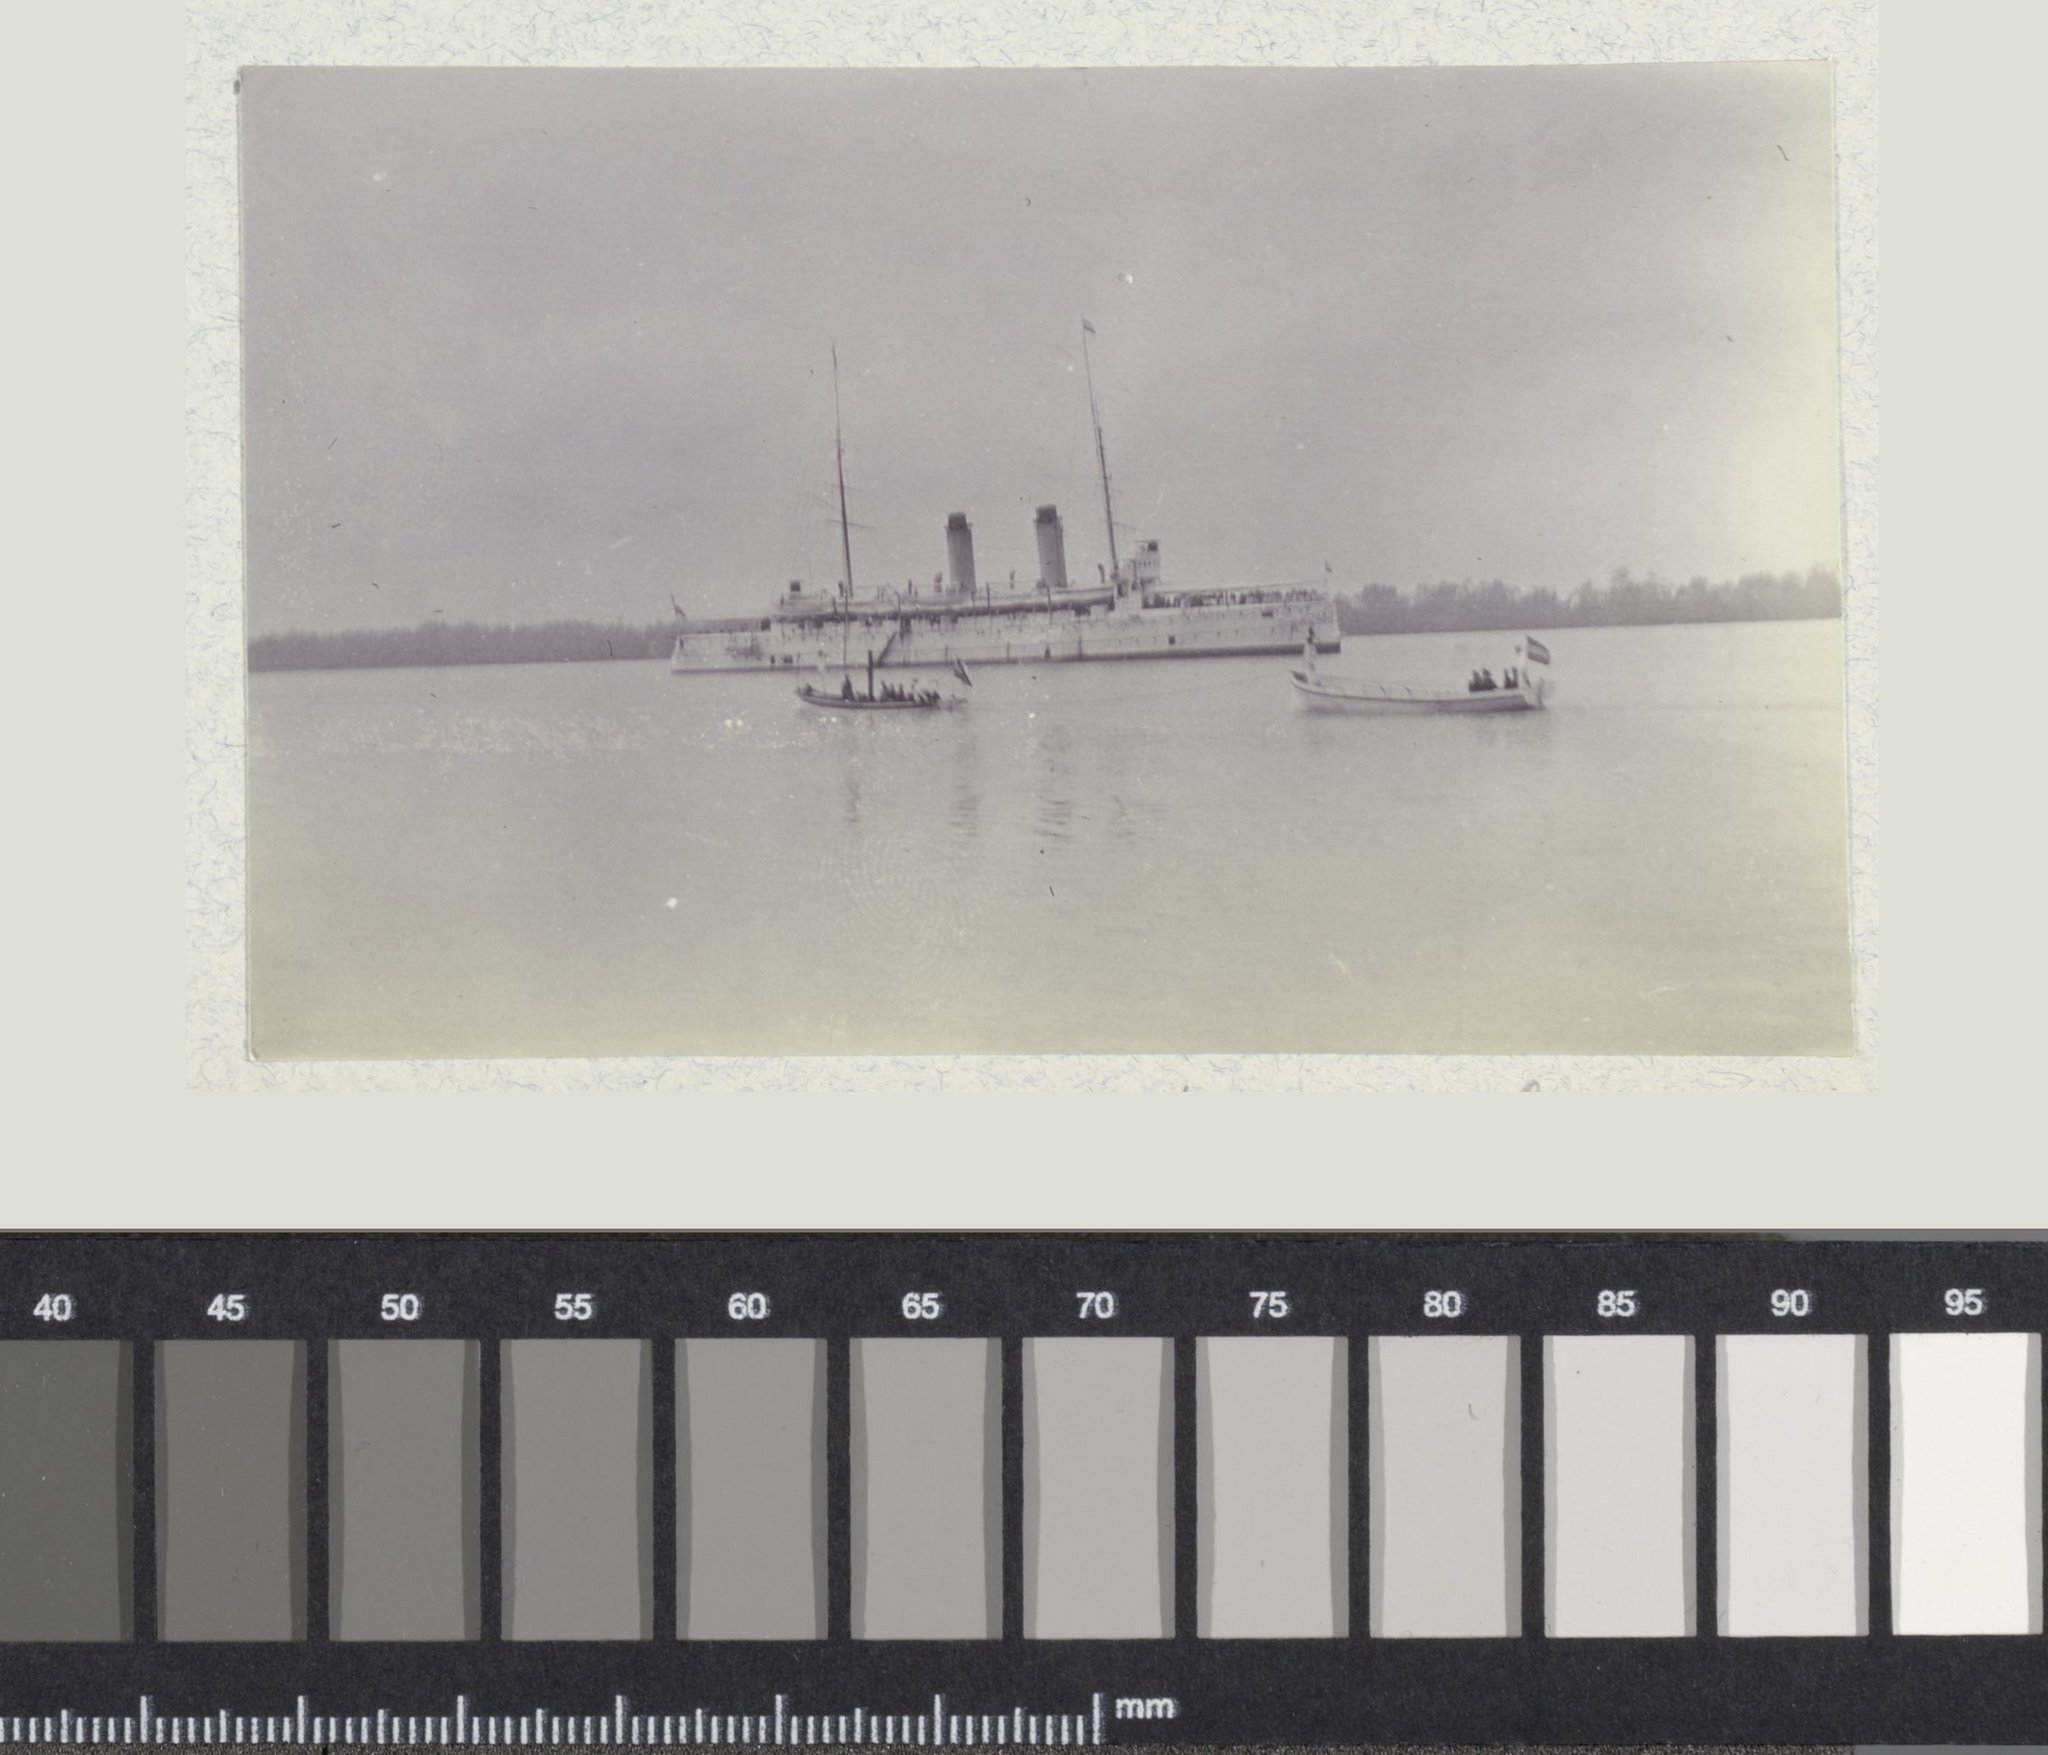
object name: photograph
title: De 'Zeeland'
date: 1905-1912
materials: photographic support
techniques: photography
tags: navy (+ motor ships), suriname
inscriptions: inscription: ‘Mei 1912 Curaçao / H.M. Zeeland’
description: Gezicht op het pantserdekschip 'H.M. Zeeland', volgens het onderschrift op Curaçao, waarschijnlijk echter op een rivier in Suriname, mei 1912. Onderdeel van het fotoalbum van de familie Boom-Gonggrijp in Suriname en Curaçao.